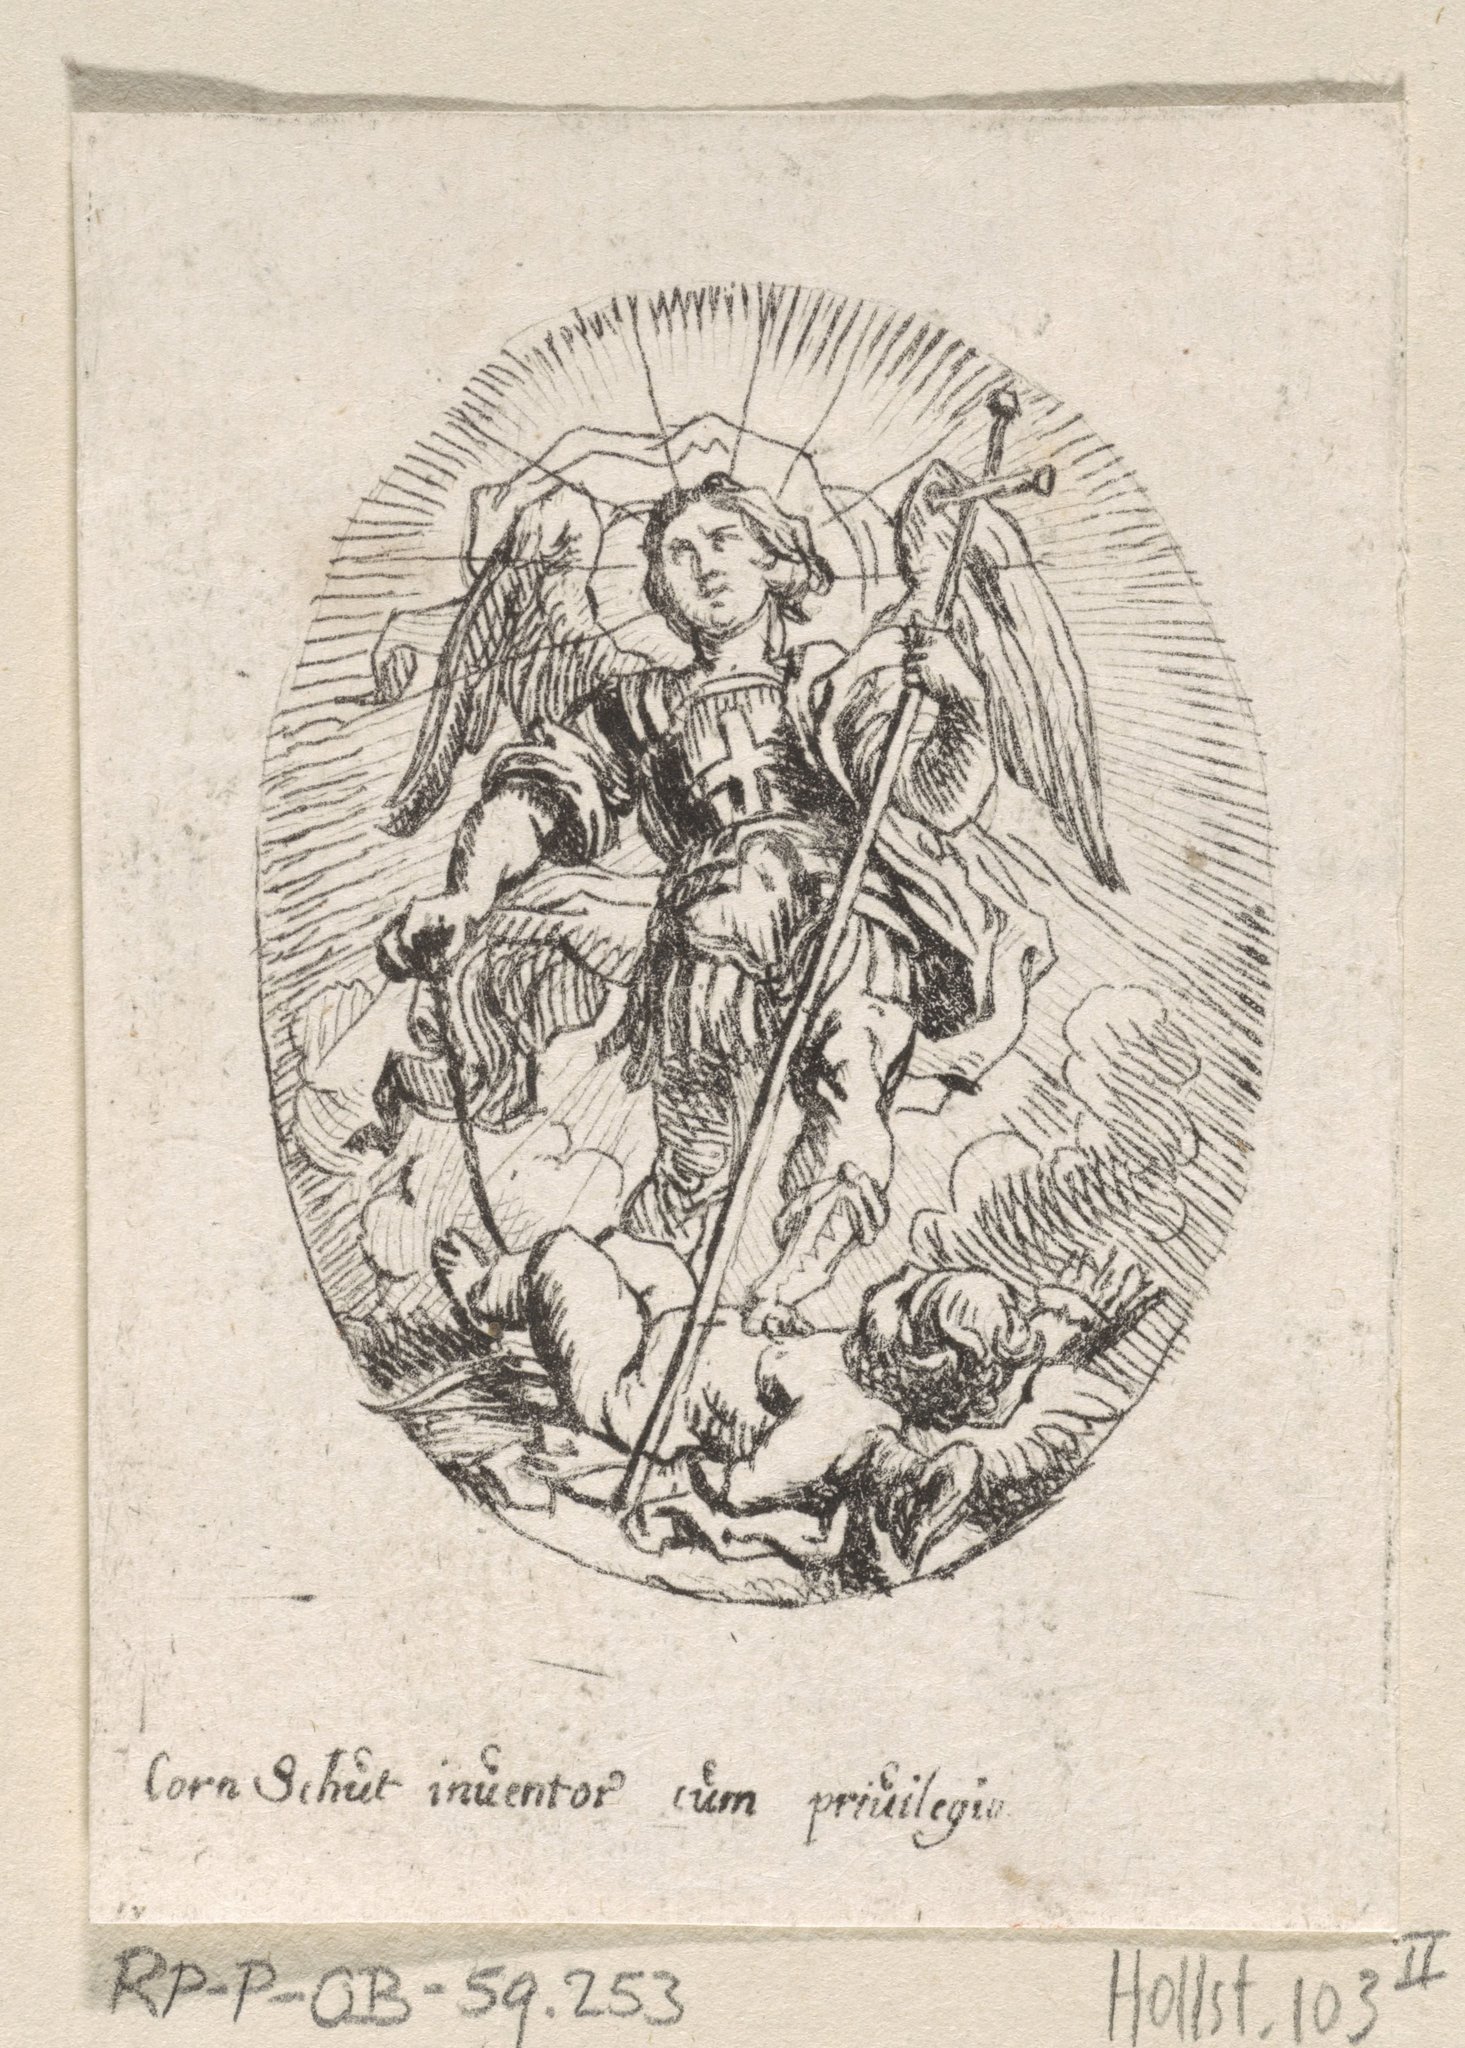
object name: print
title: H. Michaël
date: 1618-1655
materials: paper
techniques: etching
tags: the archangel michael (often in armour with sword or lance)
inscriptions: collector's mark: Lugt 240, inscription: ‘Fragment; begin en einde ontbreken.’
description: De aartsengel Michaël, met in zijn ene hand een kruis en in de andere hand een ketting, staat met zijn voet op de gevallen engel.